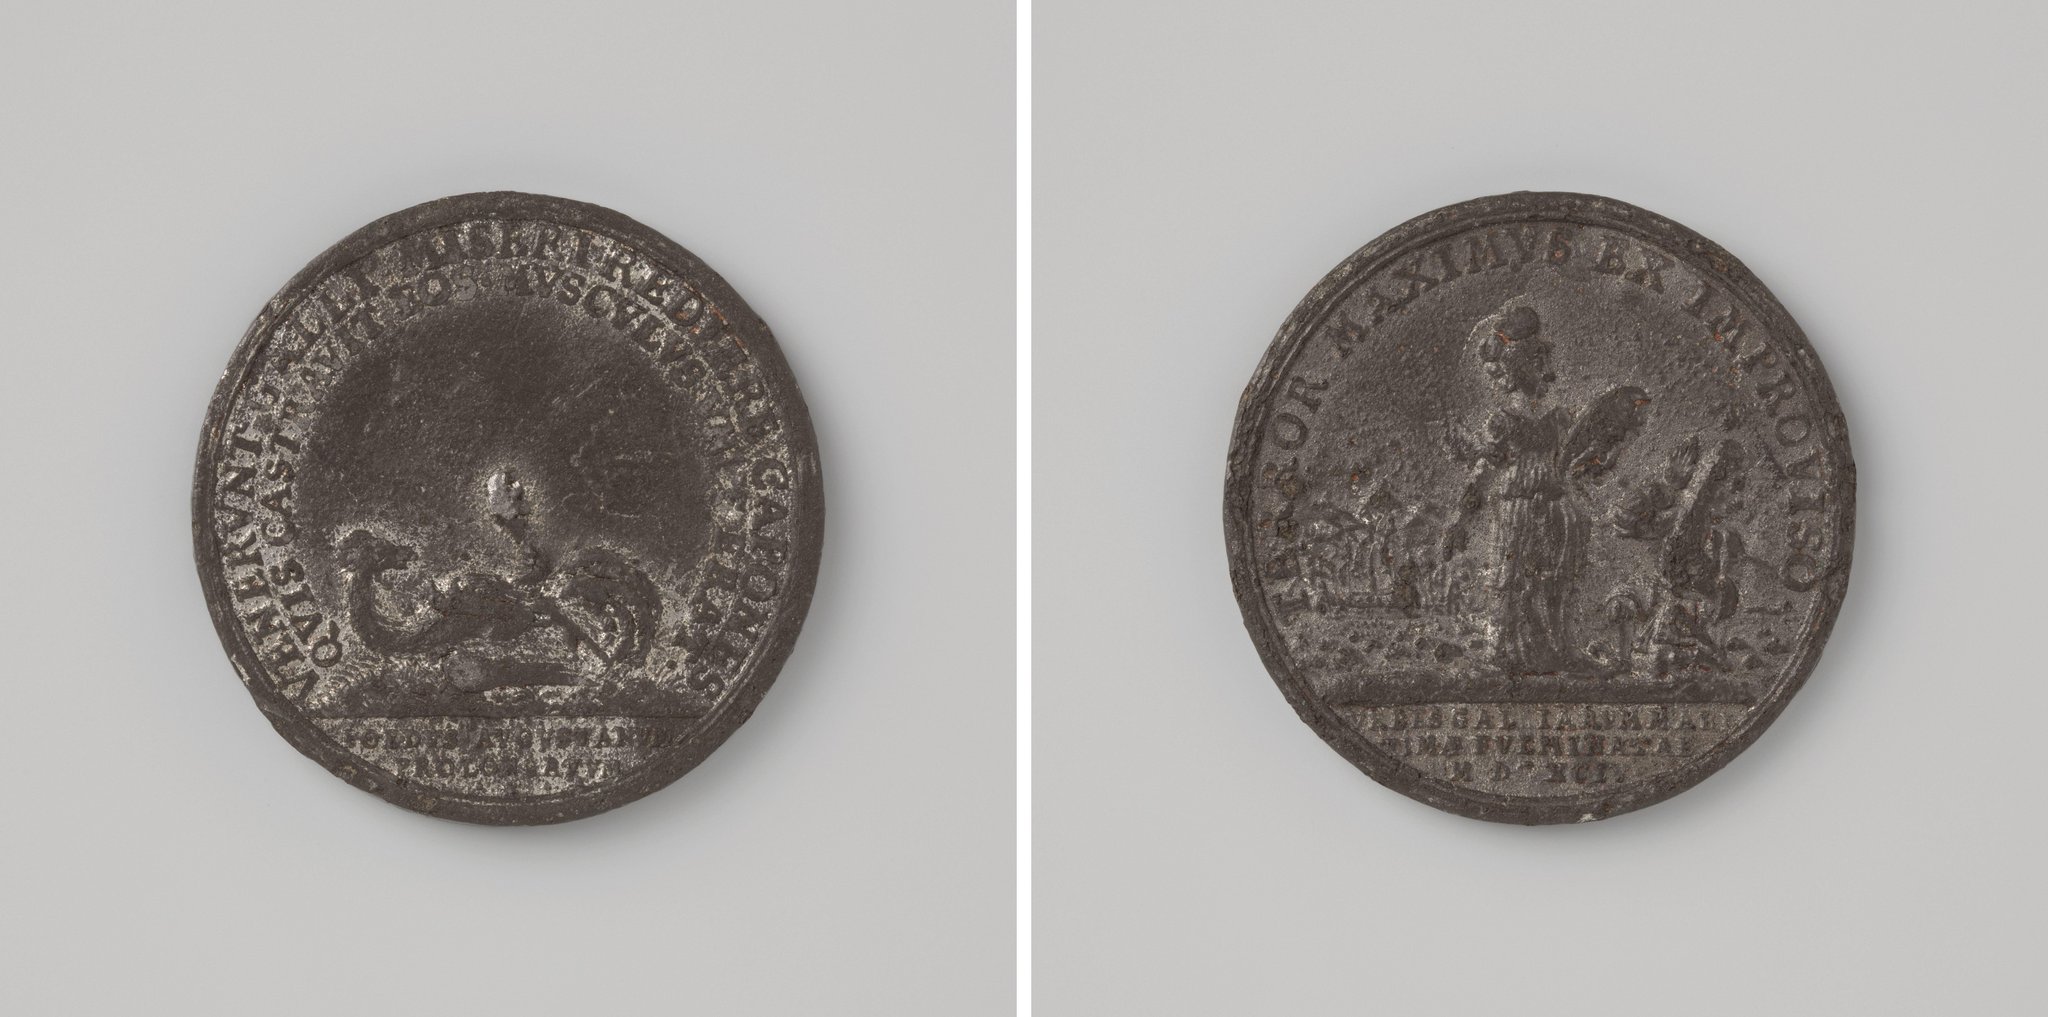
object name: history medal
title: Duitse spotpenning het bombarderen van Franse kuststeden 1694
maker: christian wermuth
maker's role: medailleur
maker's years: 1661-1739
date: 1694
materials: tin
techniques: casting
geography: gotha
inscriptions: circumscription: ‘TERROR MAXIMVS EX IMPROVISO’, inscription: ‘FOEDVS AVGVSTANVM PROLONGATVM’, circumscription: ‘VENERVNT GALLI MISERI REDIERE CAPONES / QVIS CASTRAVIT EOS MVSCVLVS VNVS ERAT’, inscription: ‘VRBES GALLIARVM MARI / TIMAE FVLMINATAE / MDCXCIV’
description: Tinnen penning met resten verzilvering, op de voorzijde een haan doodgebeten door een muis, met dubbel omschrift en afsnedetekst, op de keerzijde Pallas die, wijzend op een vurend oorlogsschip, haar schild met Gorgonshoofd naar de knielende Lodewijk XIV richt, met omschrift en afsnedetekst.